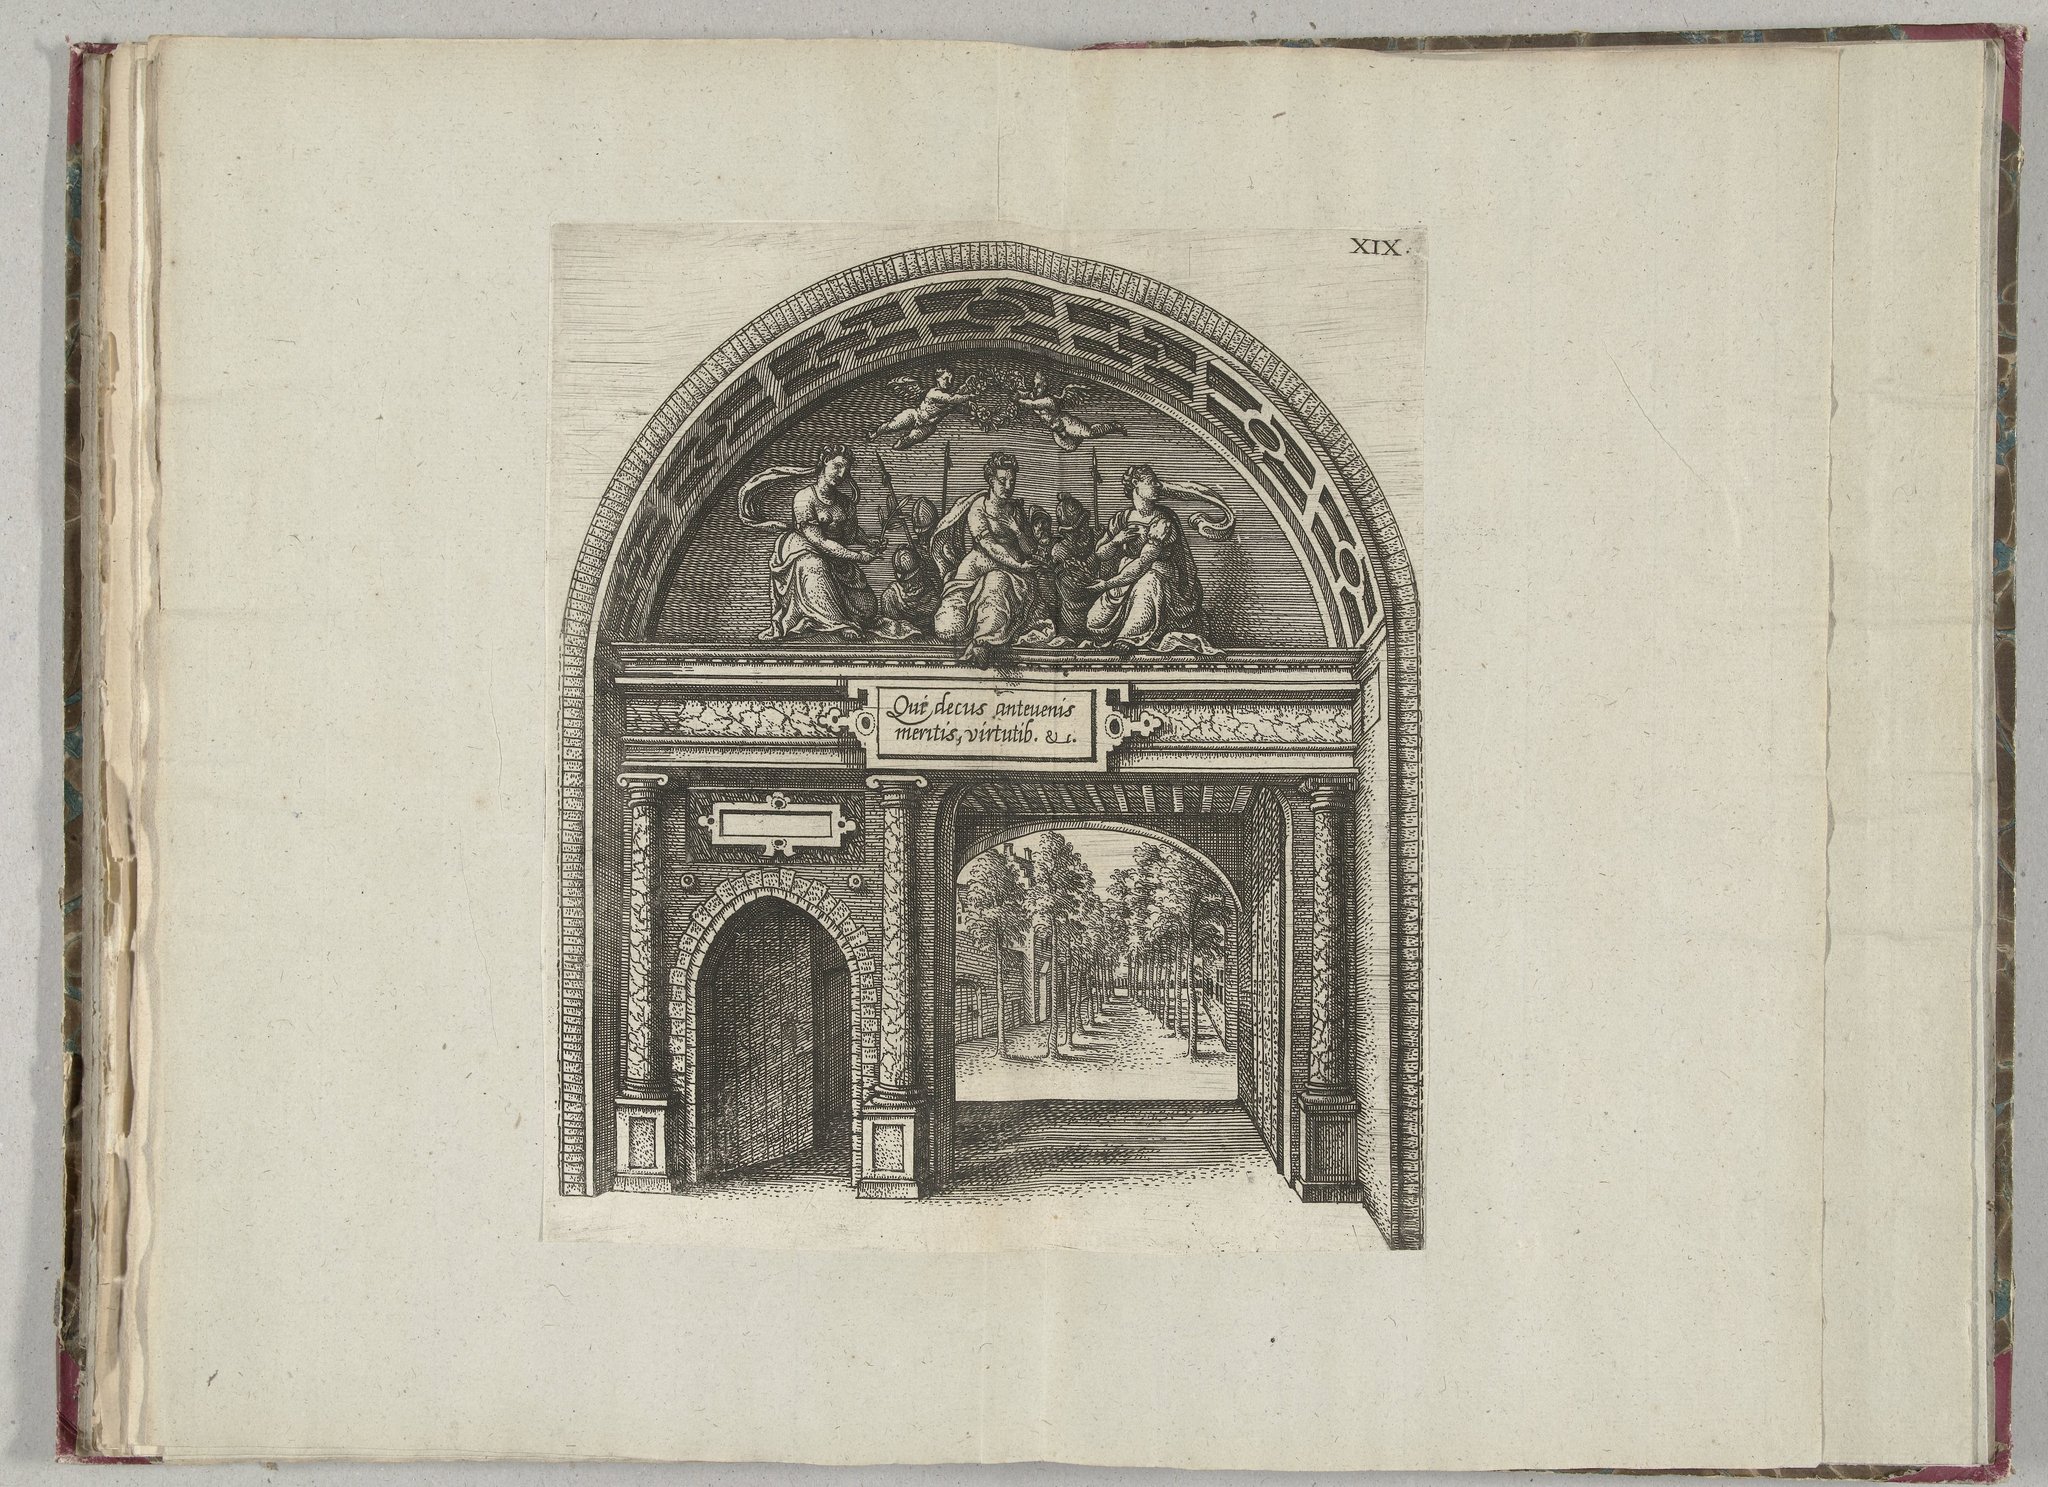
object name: print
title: Erepoort met de Drie Gratiën voor het paleis, 1582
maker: Anonymous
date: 1582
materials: paper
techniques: etching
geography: netherlands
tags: françois-hercule de valois (hertog van anjou), triumphal arch, triumphal entry and public reception, pageant, 'entrée solennelle', 'joyeuse entrée', graces (charites), generally three in number; 'gratie' (ripa), antwerp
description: Illustratie in: La ioyeuse et magnifique entrée de Françoys ... Duc de Brabant, d'Anjou, Alençon, Berri et c. en sa tres-renommée ville d'Anvers, Christoffel Plantijn, Antwerpen 1582, pl. XIX. Boek in de Rijksmuseum Research Library met signatuur: 327 I 8.